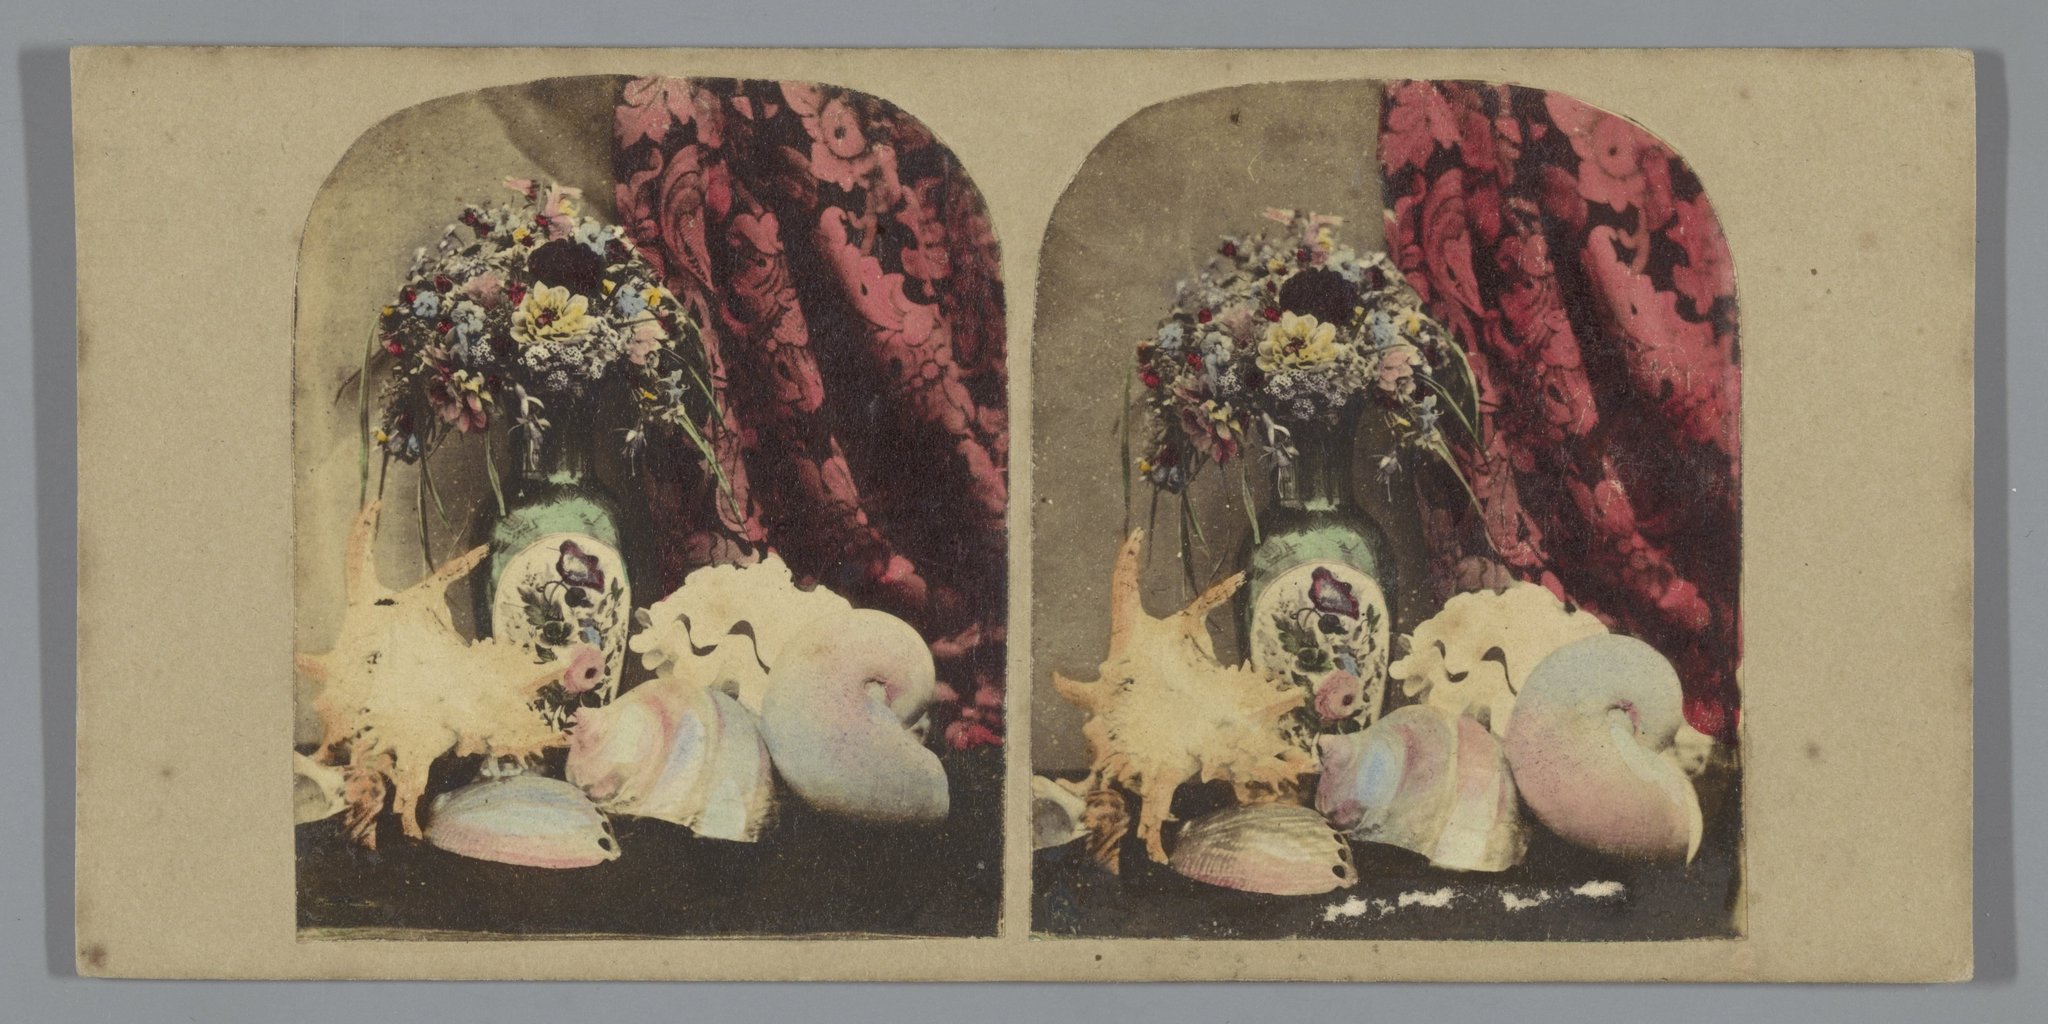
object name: stereograph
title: Stilleven met een boeket in een vaas en schelpen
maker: Anonymous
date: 1852-1863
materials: cardboard, paper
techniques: albumen print, hand coloring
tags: still life of related objects, flowers in a vase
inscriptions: inscription: ‘[...]’